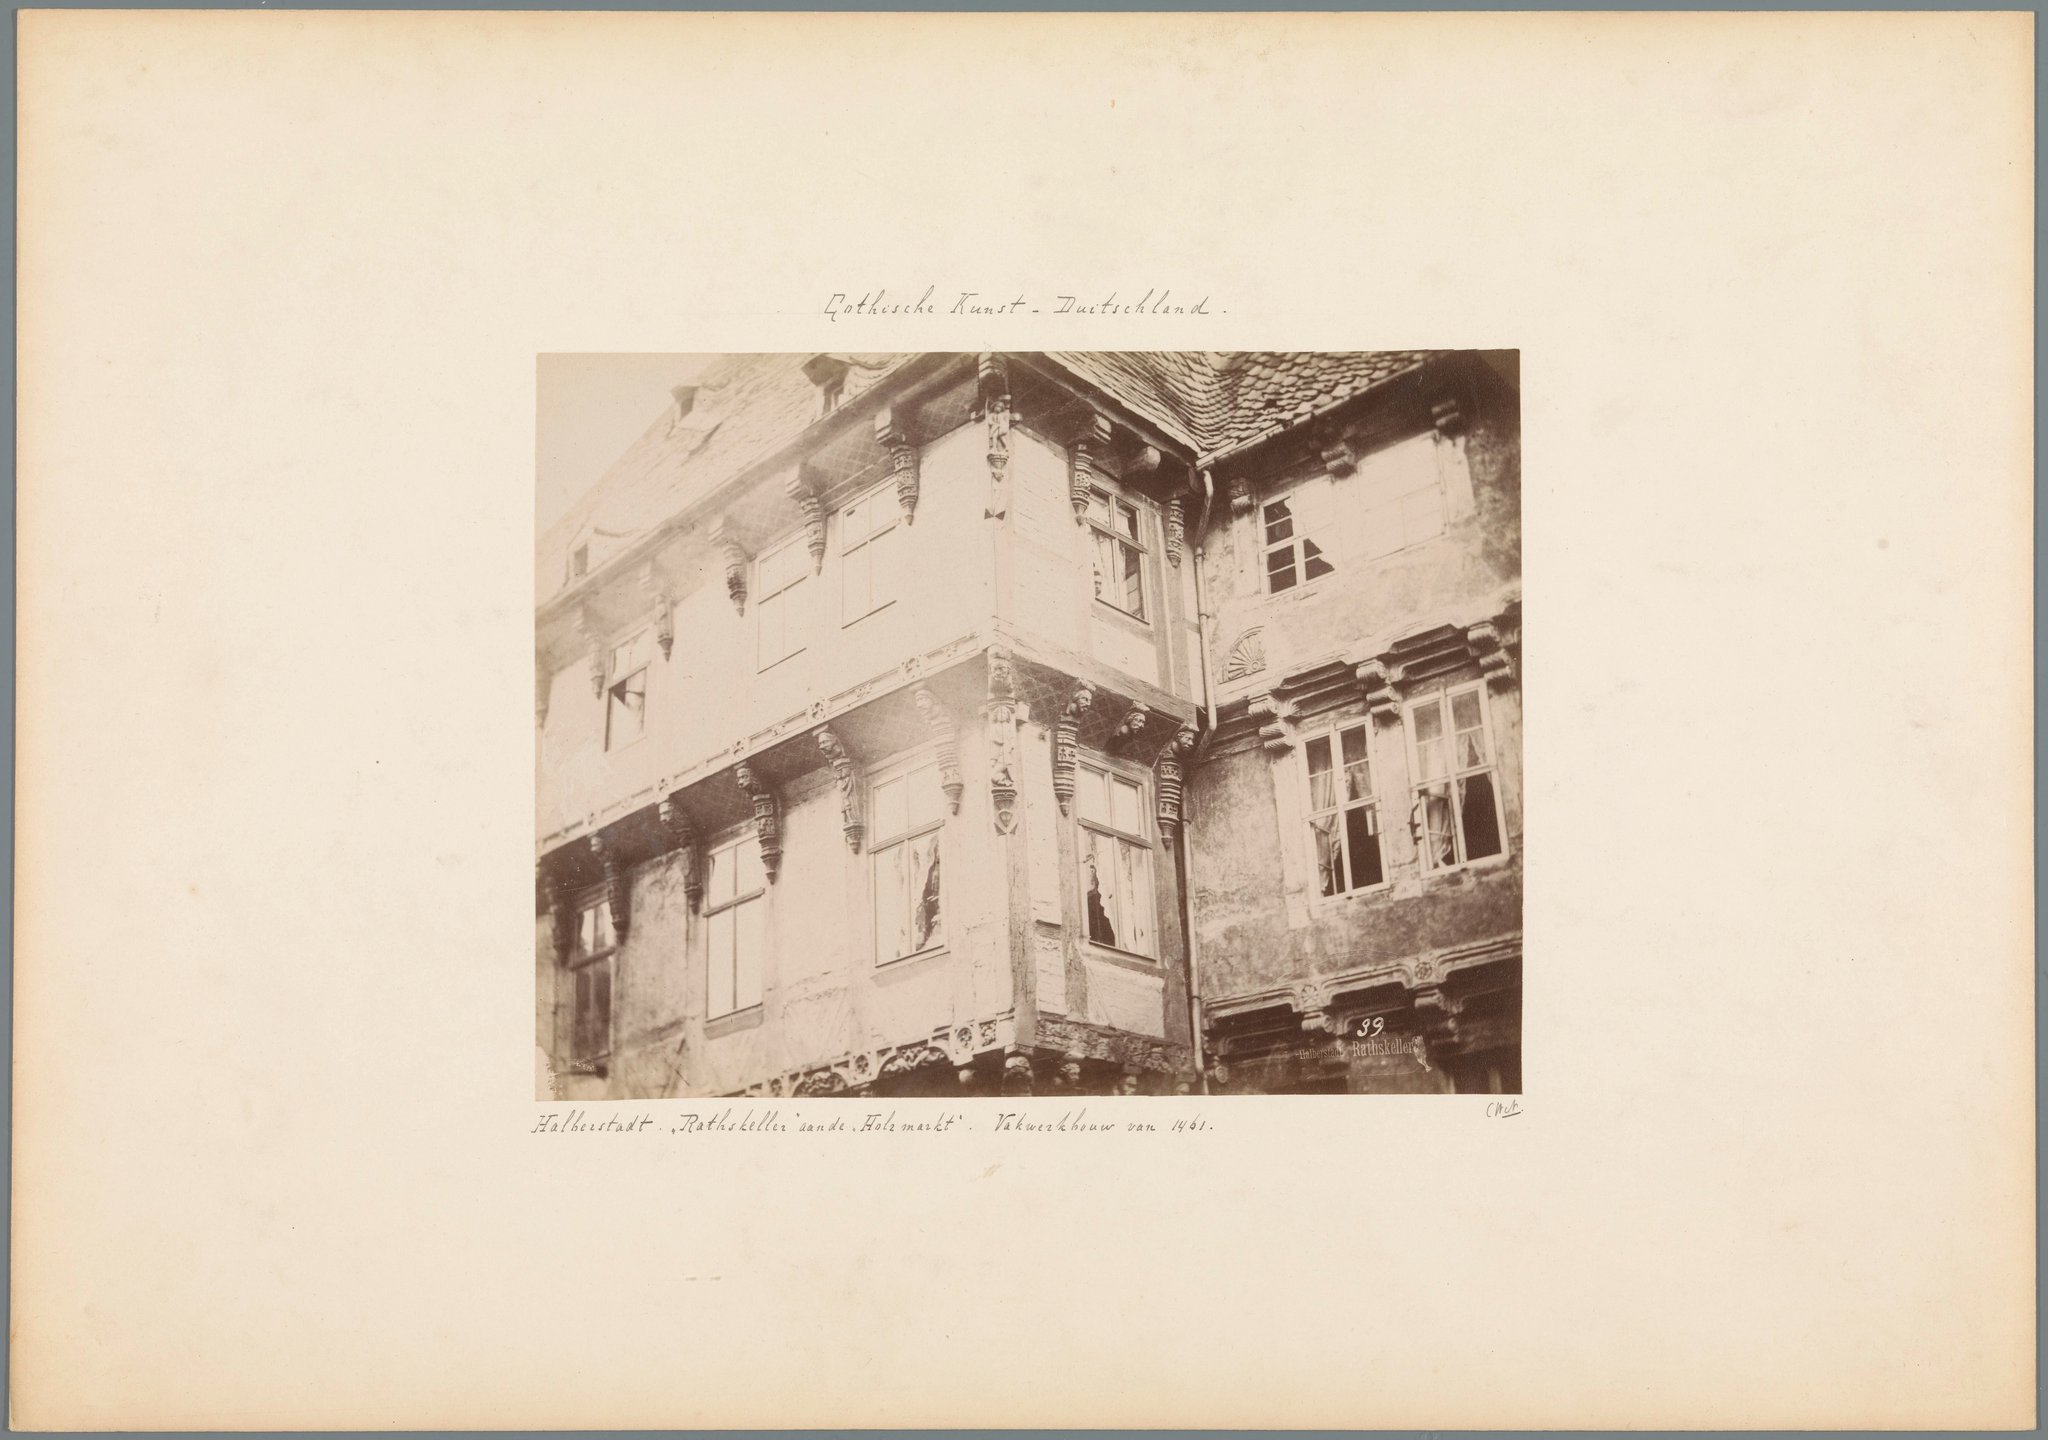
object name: photograph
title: Detail van de Ratskeller te Halberstadt, gedecoreerd met mensen en dierenkoppen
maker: Anonymous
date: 1875-1900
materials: cardboard, photographic support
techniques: albumen print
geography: halberstadt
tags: ornament derived from animal forms, townhall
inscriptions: inscription: ‘CWN.’, number: ‘39’, collector's mark: ‘KUNSTNIJVERHEIDSCHOOL QUELLINUS AMSTERDAM FRANS HALSSTRAAT 14.’, collector's mark: ‘INSTITUUT VOOR KUNST-NIJVERHEIDSONDERWIJS GABRIËL METSUSTRAAT No. 16 AMSTERDAM’, inscription: ‘Gothische Kunst - Duitschland.’